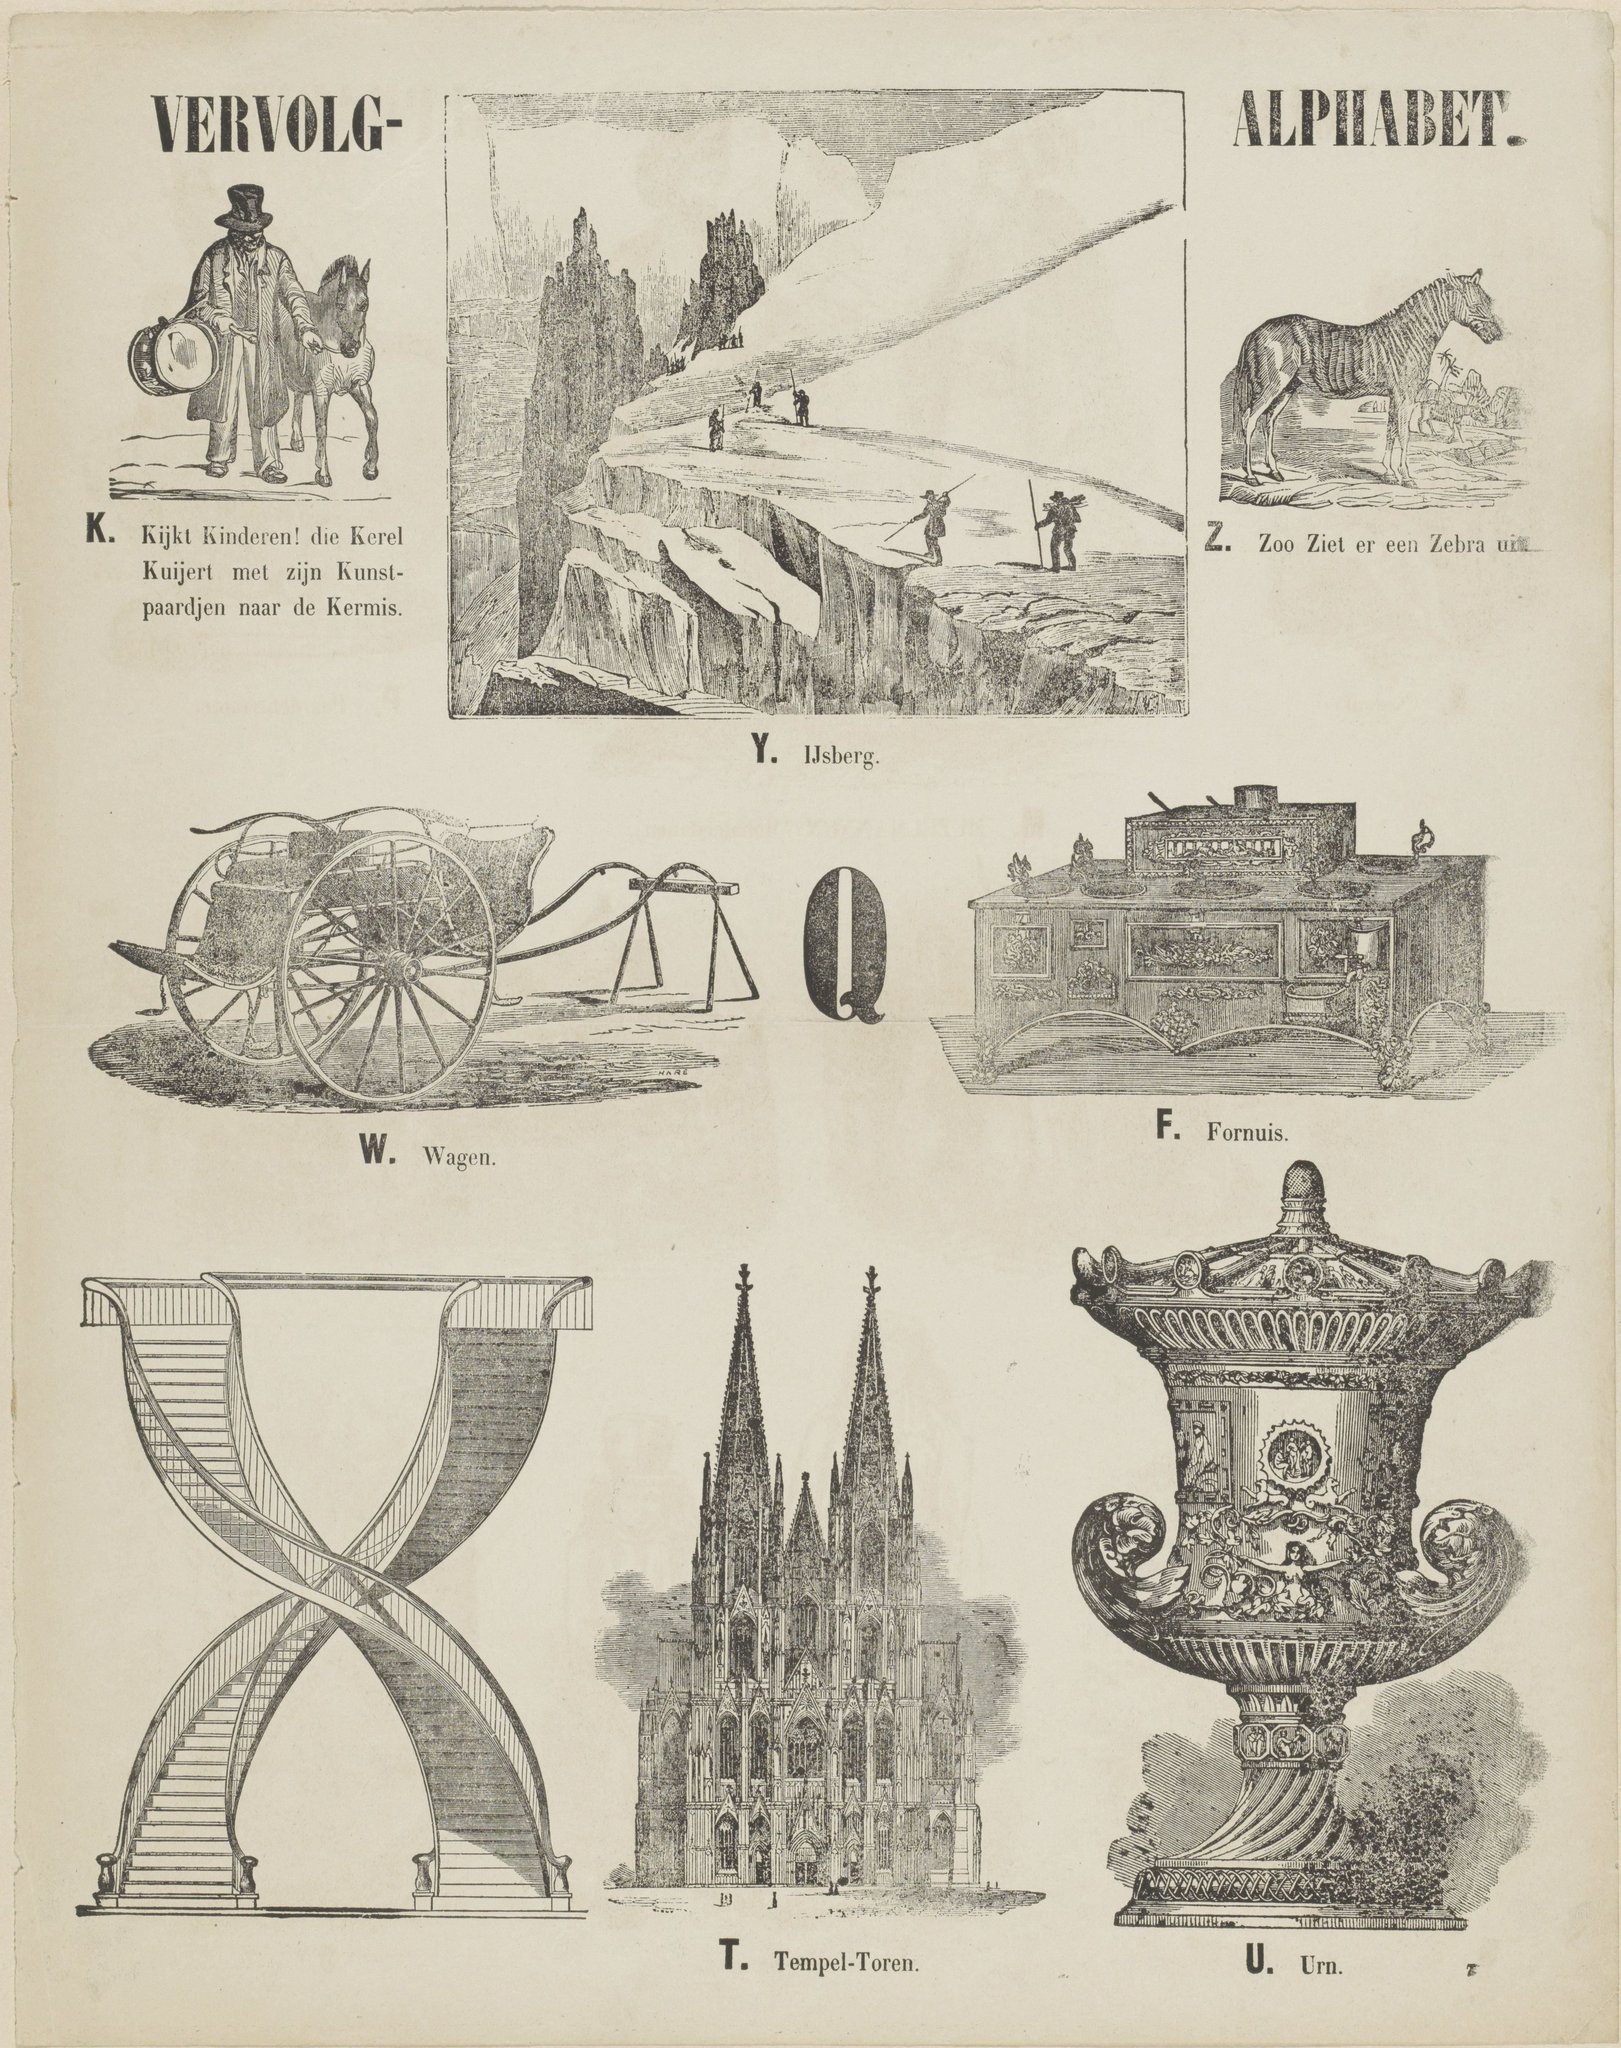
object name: popular print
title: Vervolg-alphabet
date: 1861-1929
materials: paper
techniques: letterpress printing, engraving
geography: europe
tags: hoofed animals (with name), iceberg, letters, alphabet, script, urn, heating stove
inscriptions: collector's mark: Lugt 2760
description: Blad met 8 voorstellingen van de letters van het alfabet (K, Z, Y, W, Q, F, X, T en U) geïllustreerd met voorwerpen, dieren en figuren waarvan de woorden met de betreffende letter beginnen. Onder enkele voorstellingen een onderschrift in boekdruk.